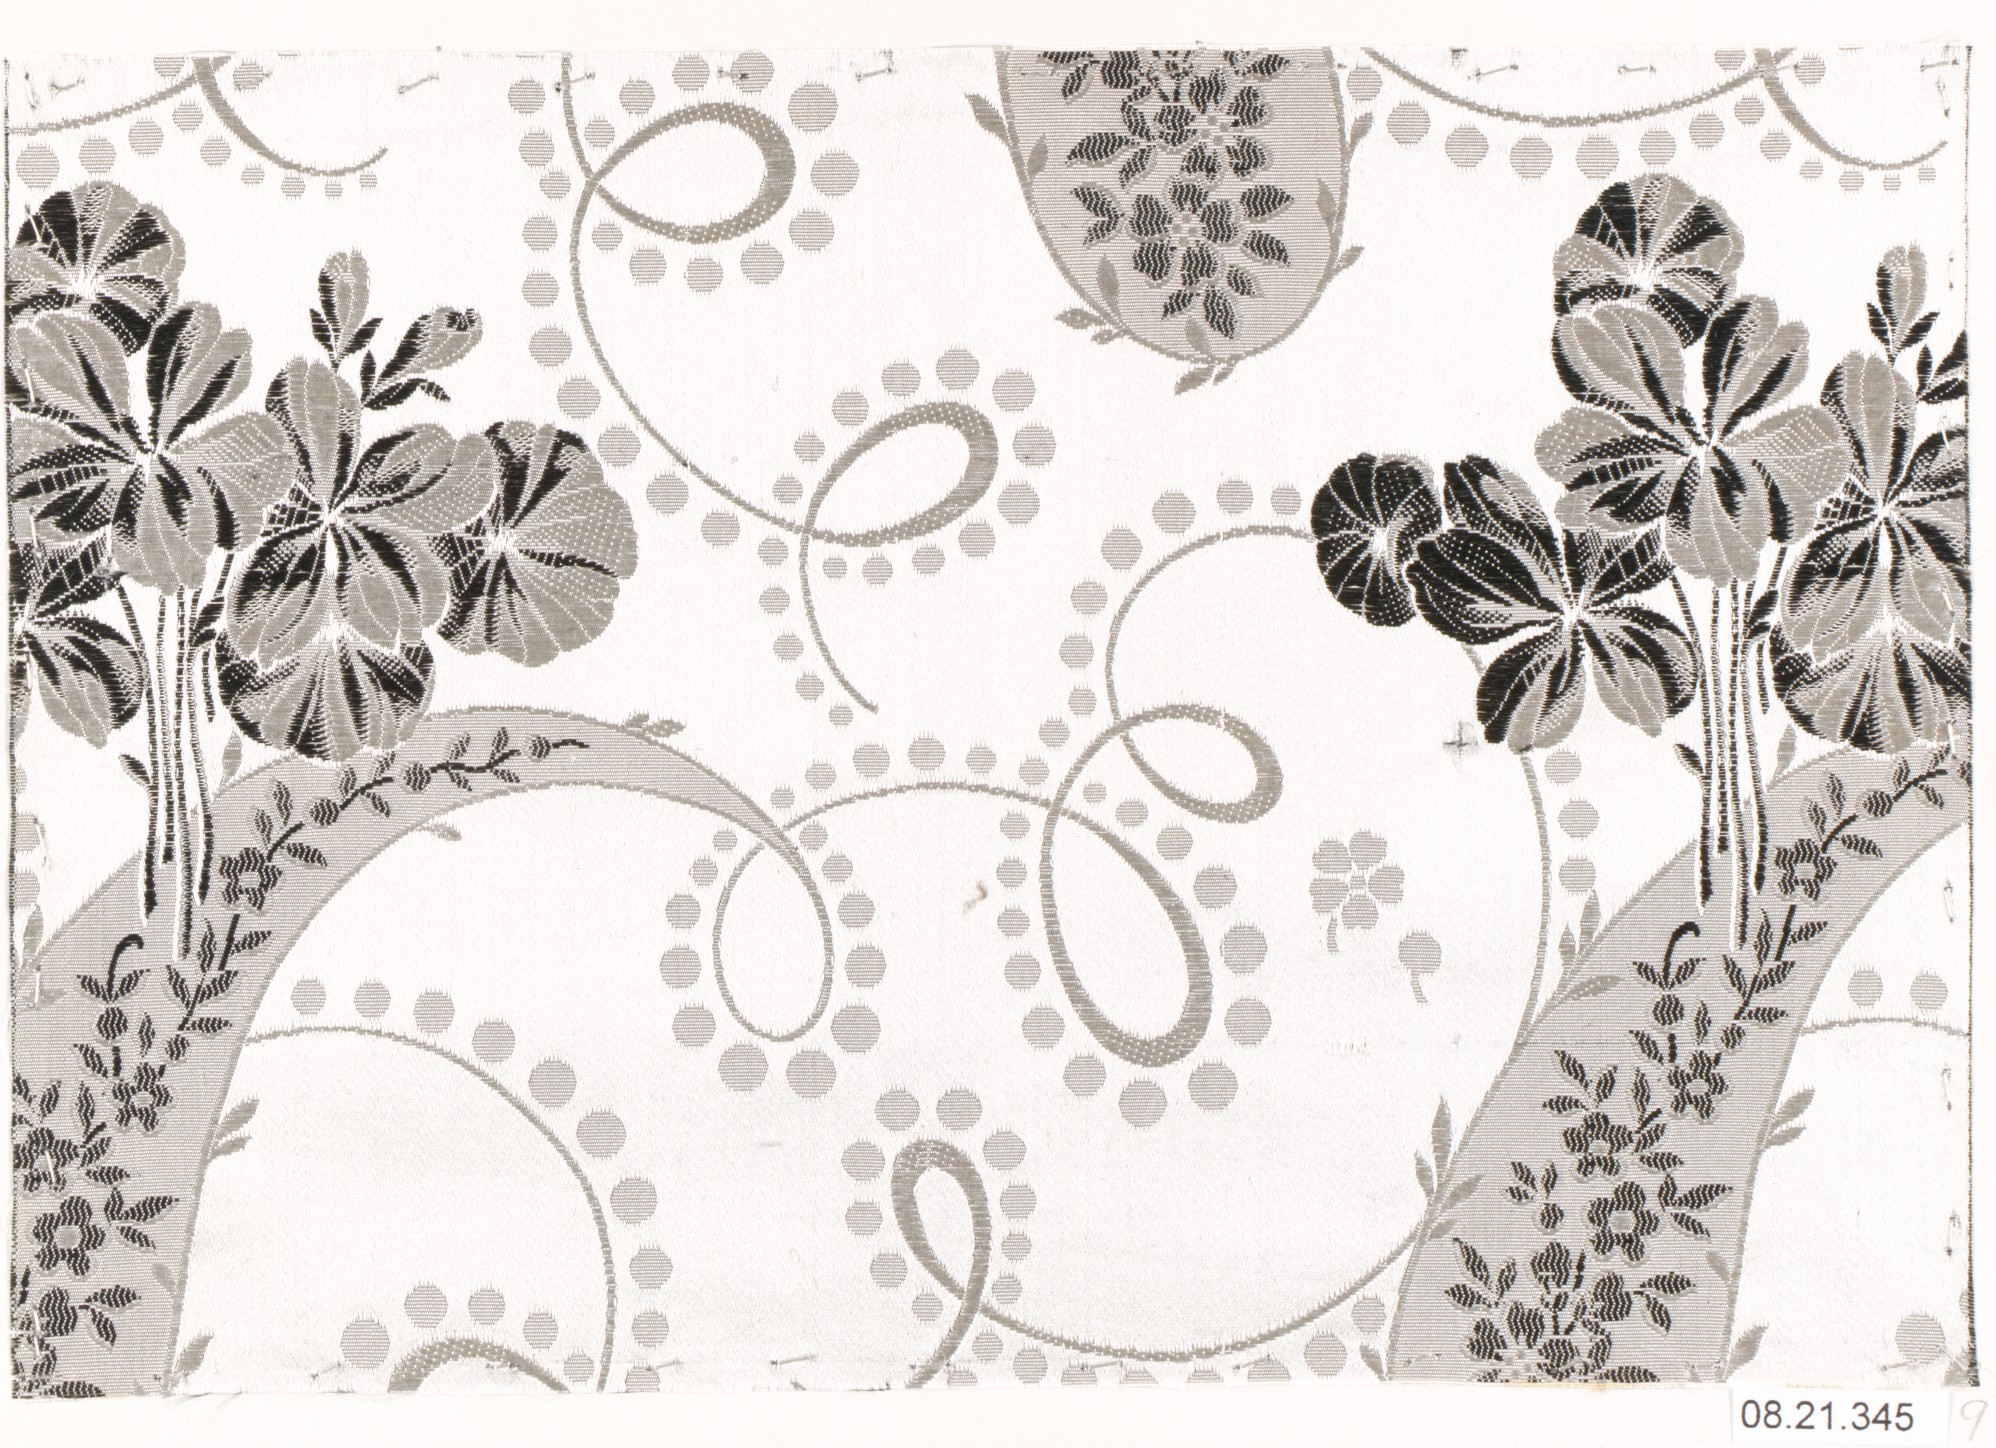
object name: textile sample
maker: Anonymous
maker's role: designer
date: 1900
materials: silk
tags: flowers